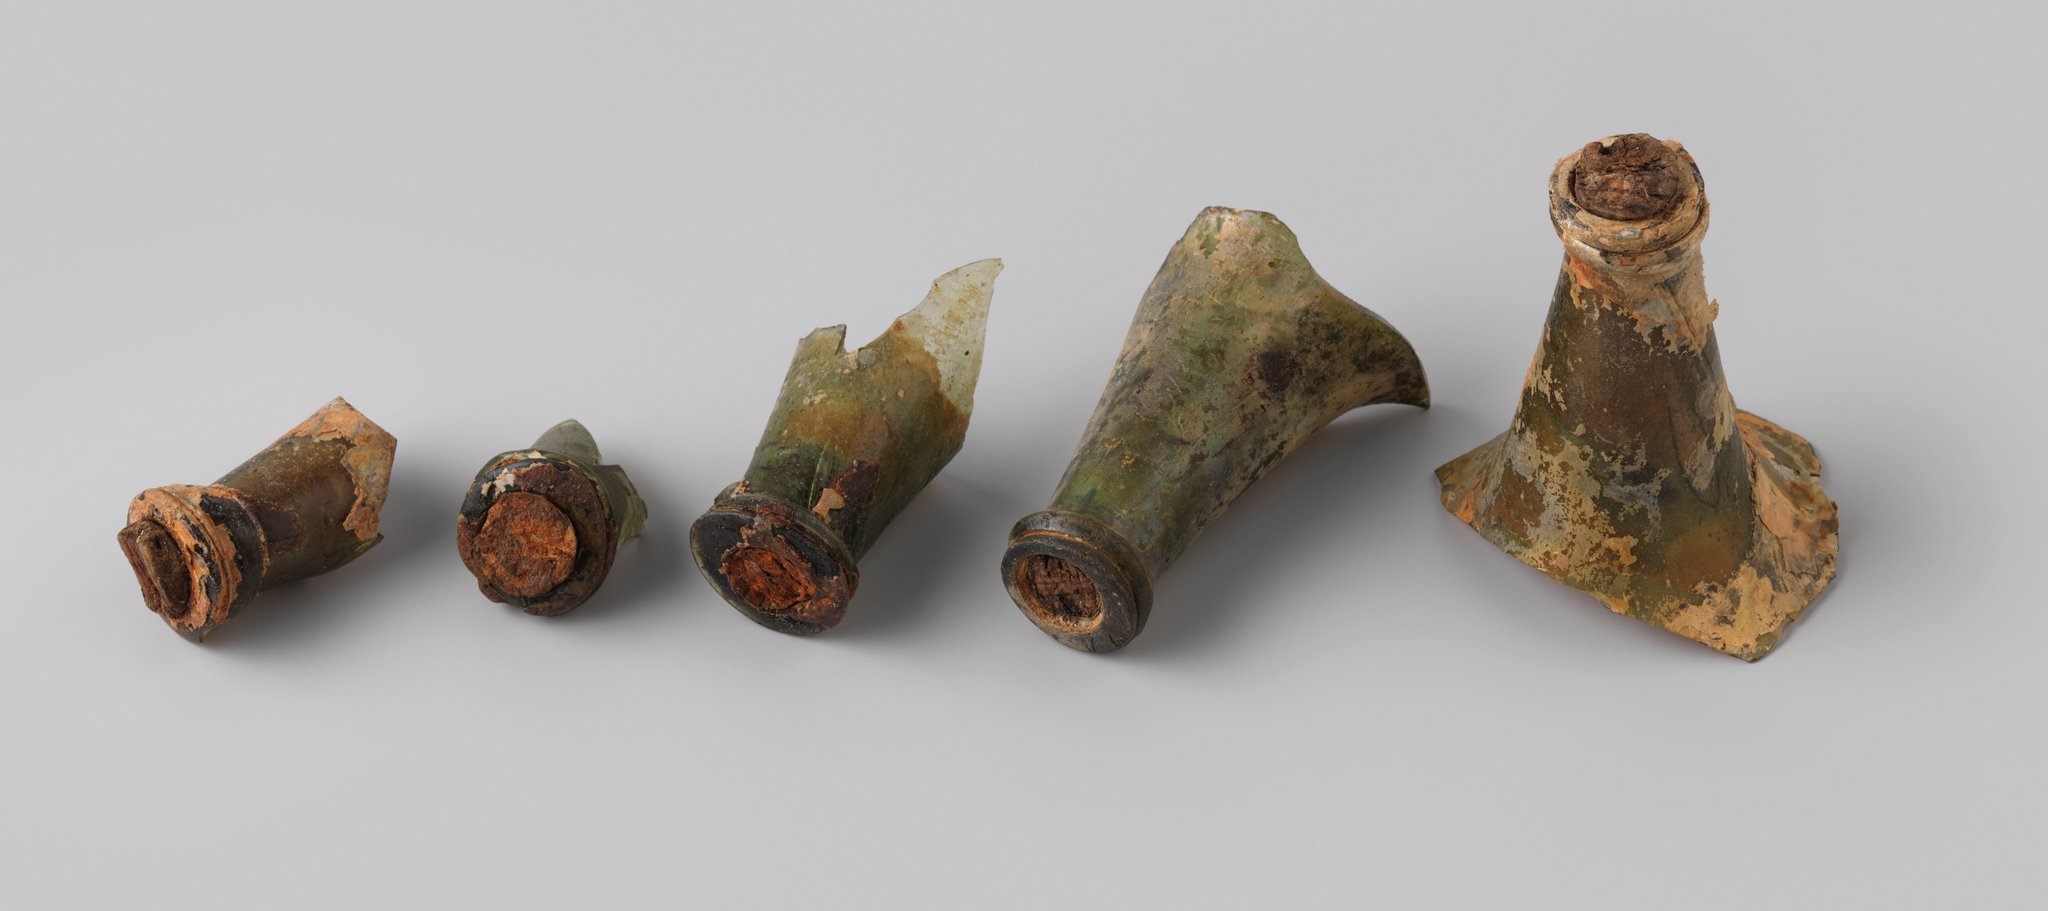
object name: wine bottle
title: Halzen met kruk van wijnflessen uit het wrak van de Oost-Indiëvaarder Hollandia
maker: Anonymous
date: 1700-1743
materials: cork, glass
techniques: green glass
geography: netherlands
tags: verenigde oostindische compagnie, hollandia (schip), annet